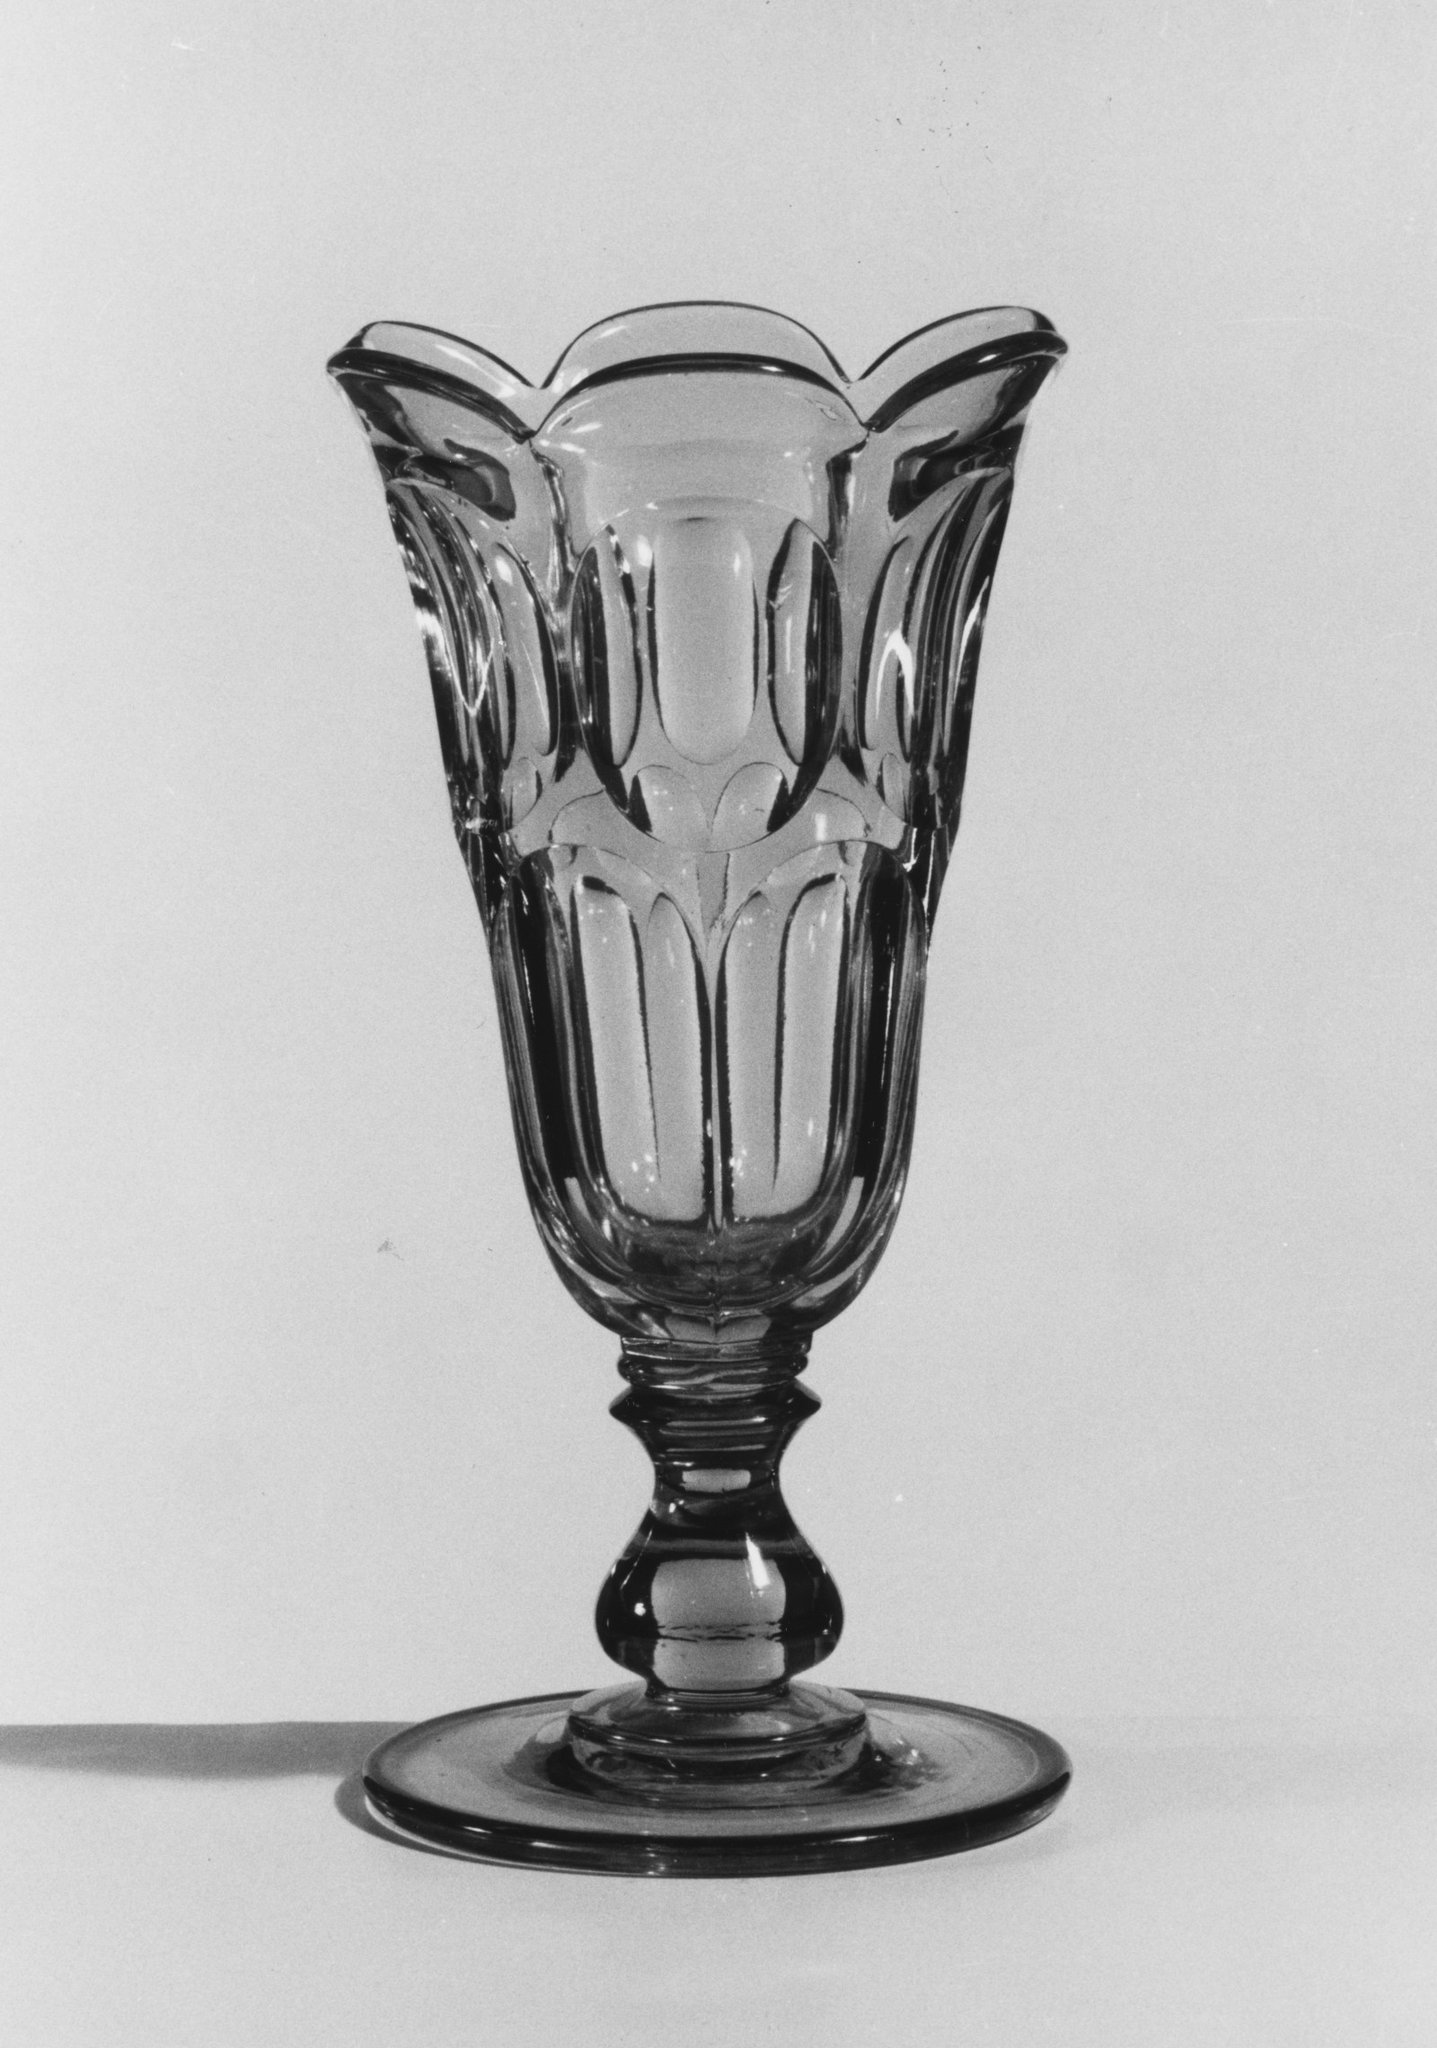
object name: celery vase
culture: american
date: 1840-1850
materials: glass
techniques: pressed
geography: united states